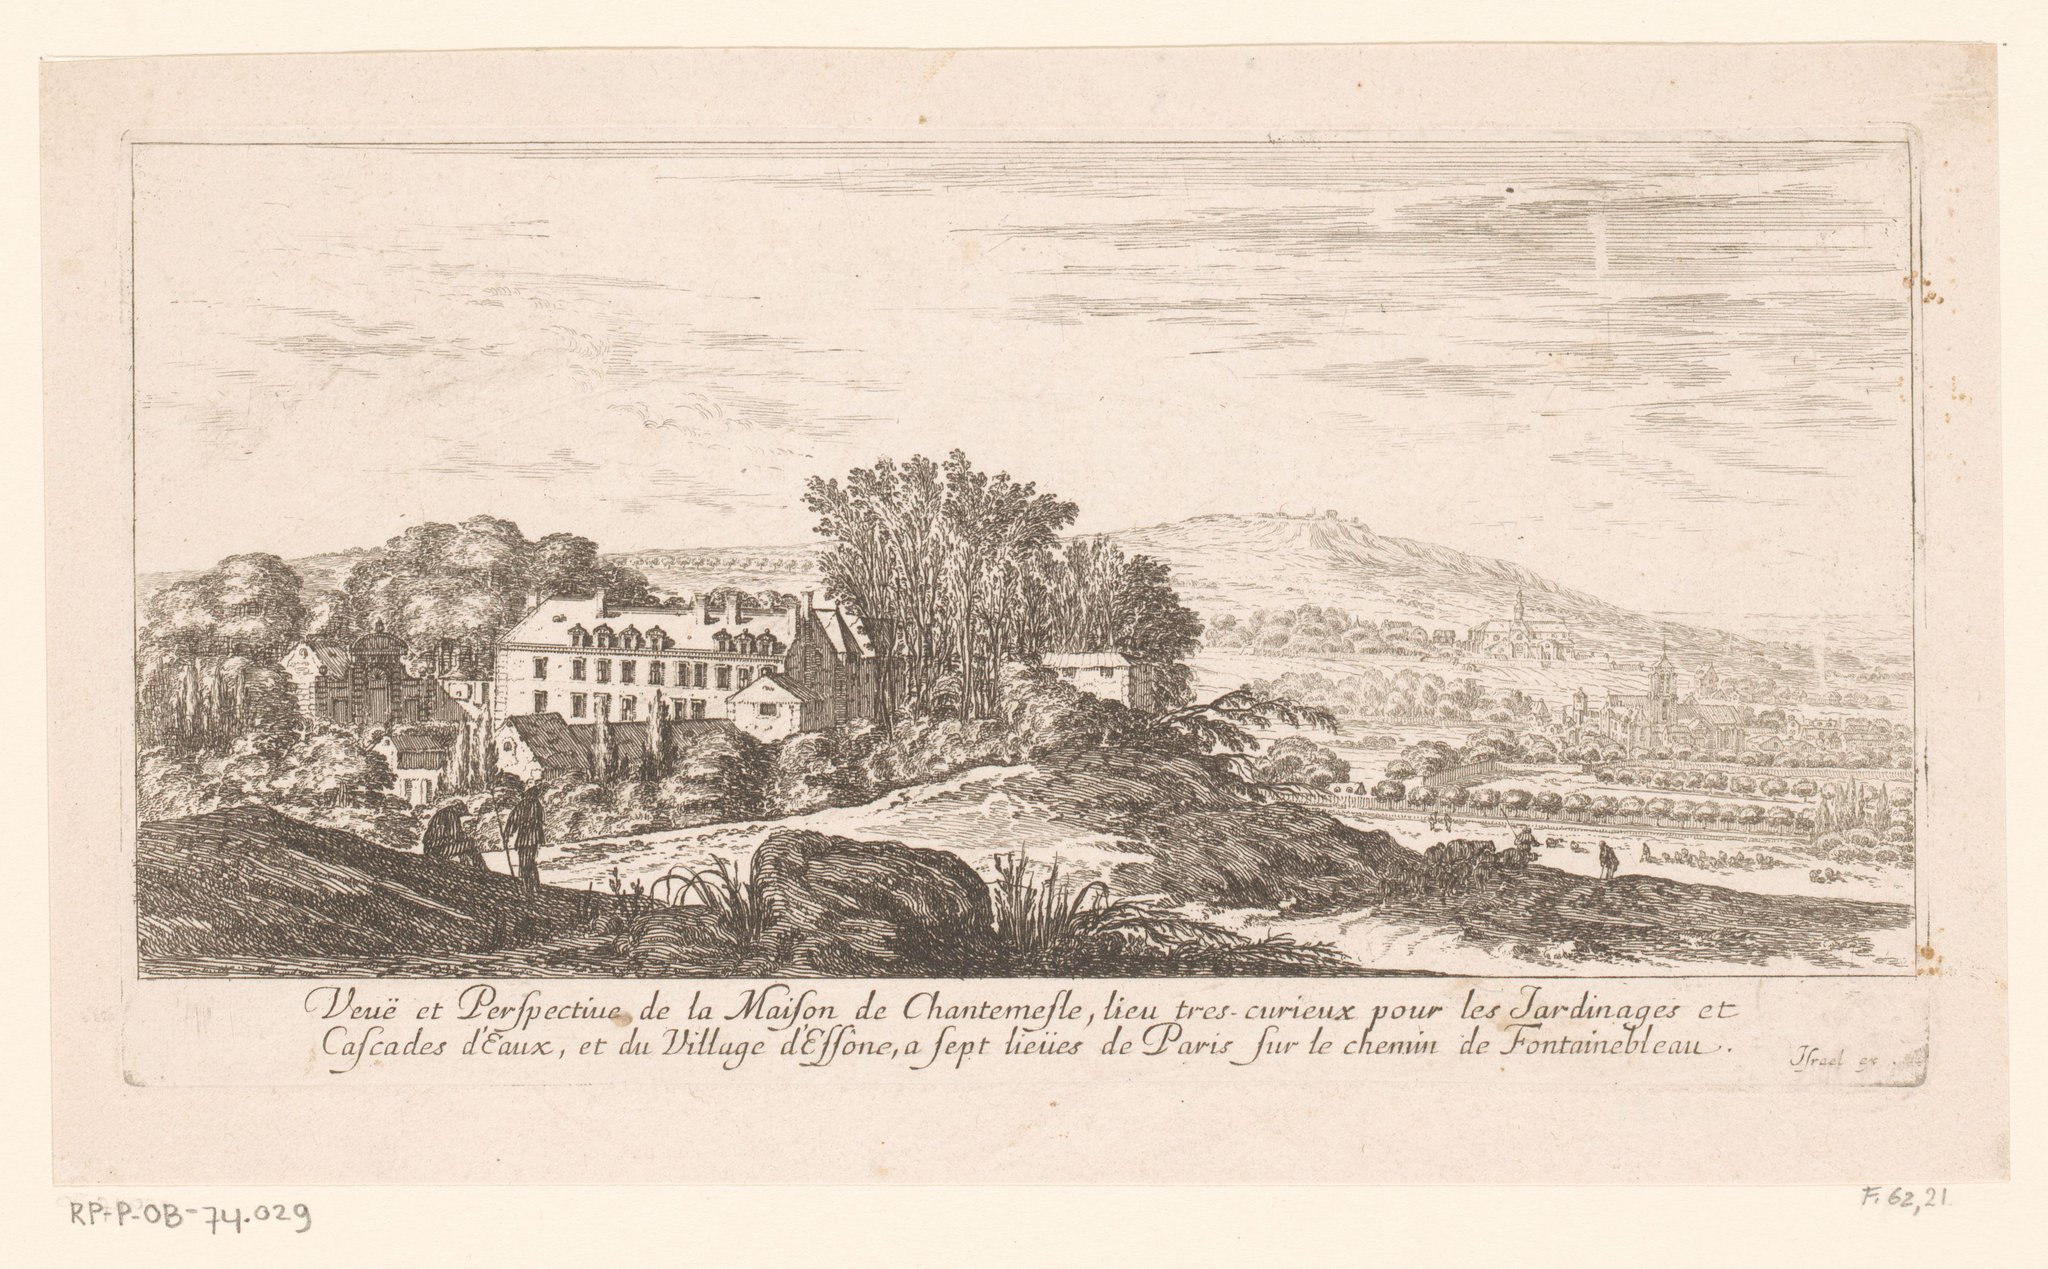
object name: print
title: Gezichten op diverse kastelen en landschappen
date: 1651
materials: paper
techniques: engraving, etching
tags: landscape with tower or castle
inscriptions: collector's mark: Lugt 240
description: Prent maakt deel uit van een ongenummerde serie van 22 prenten.